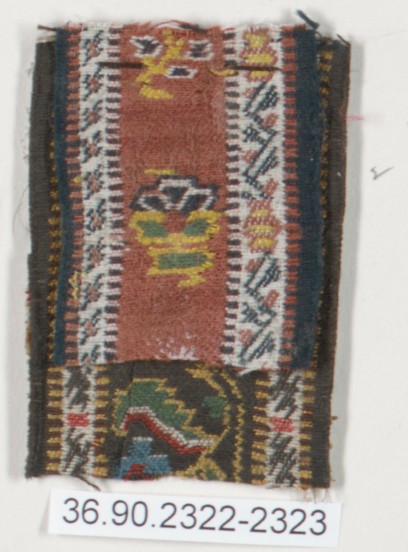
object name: border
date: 1801-1900